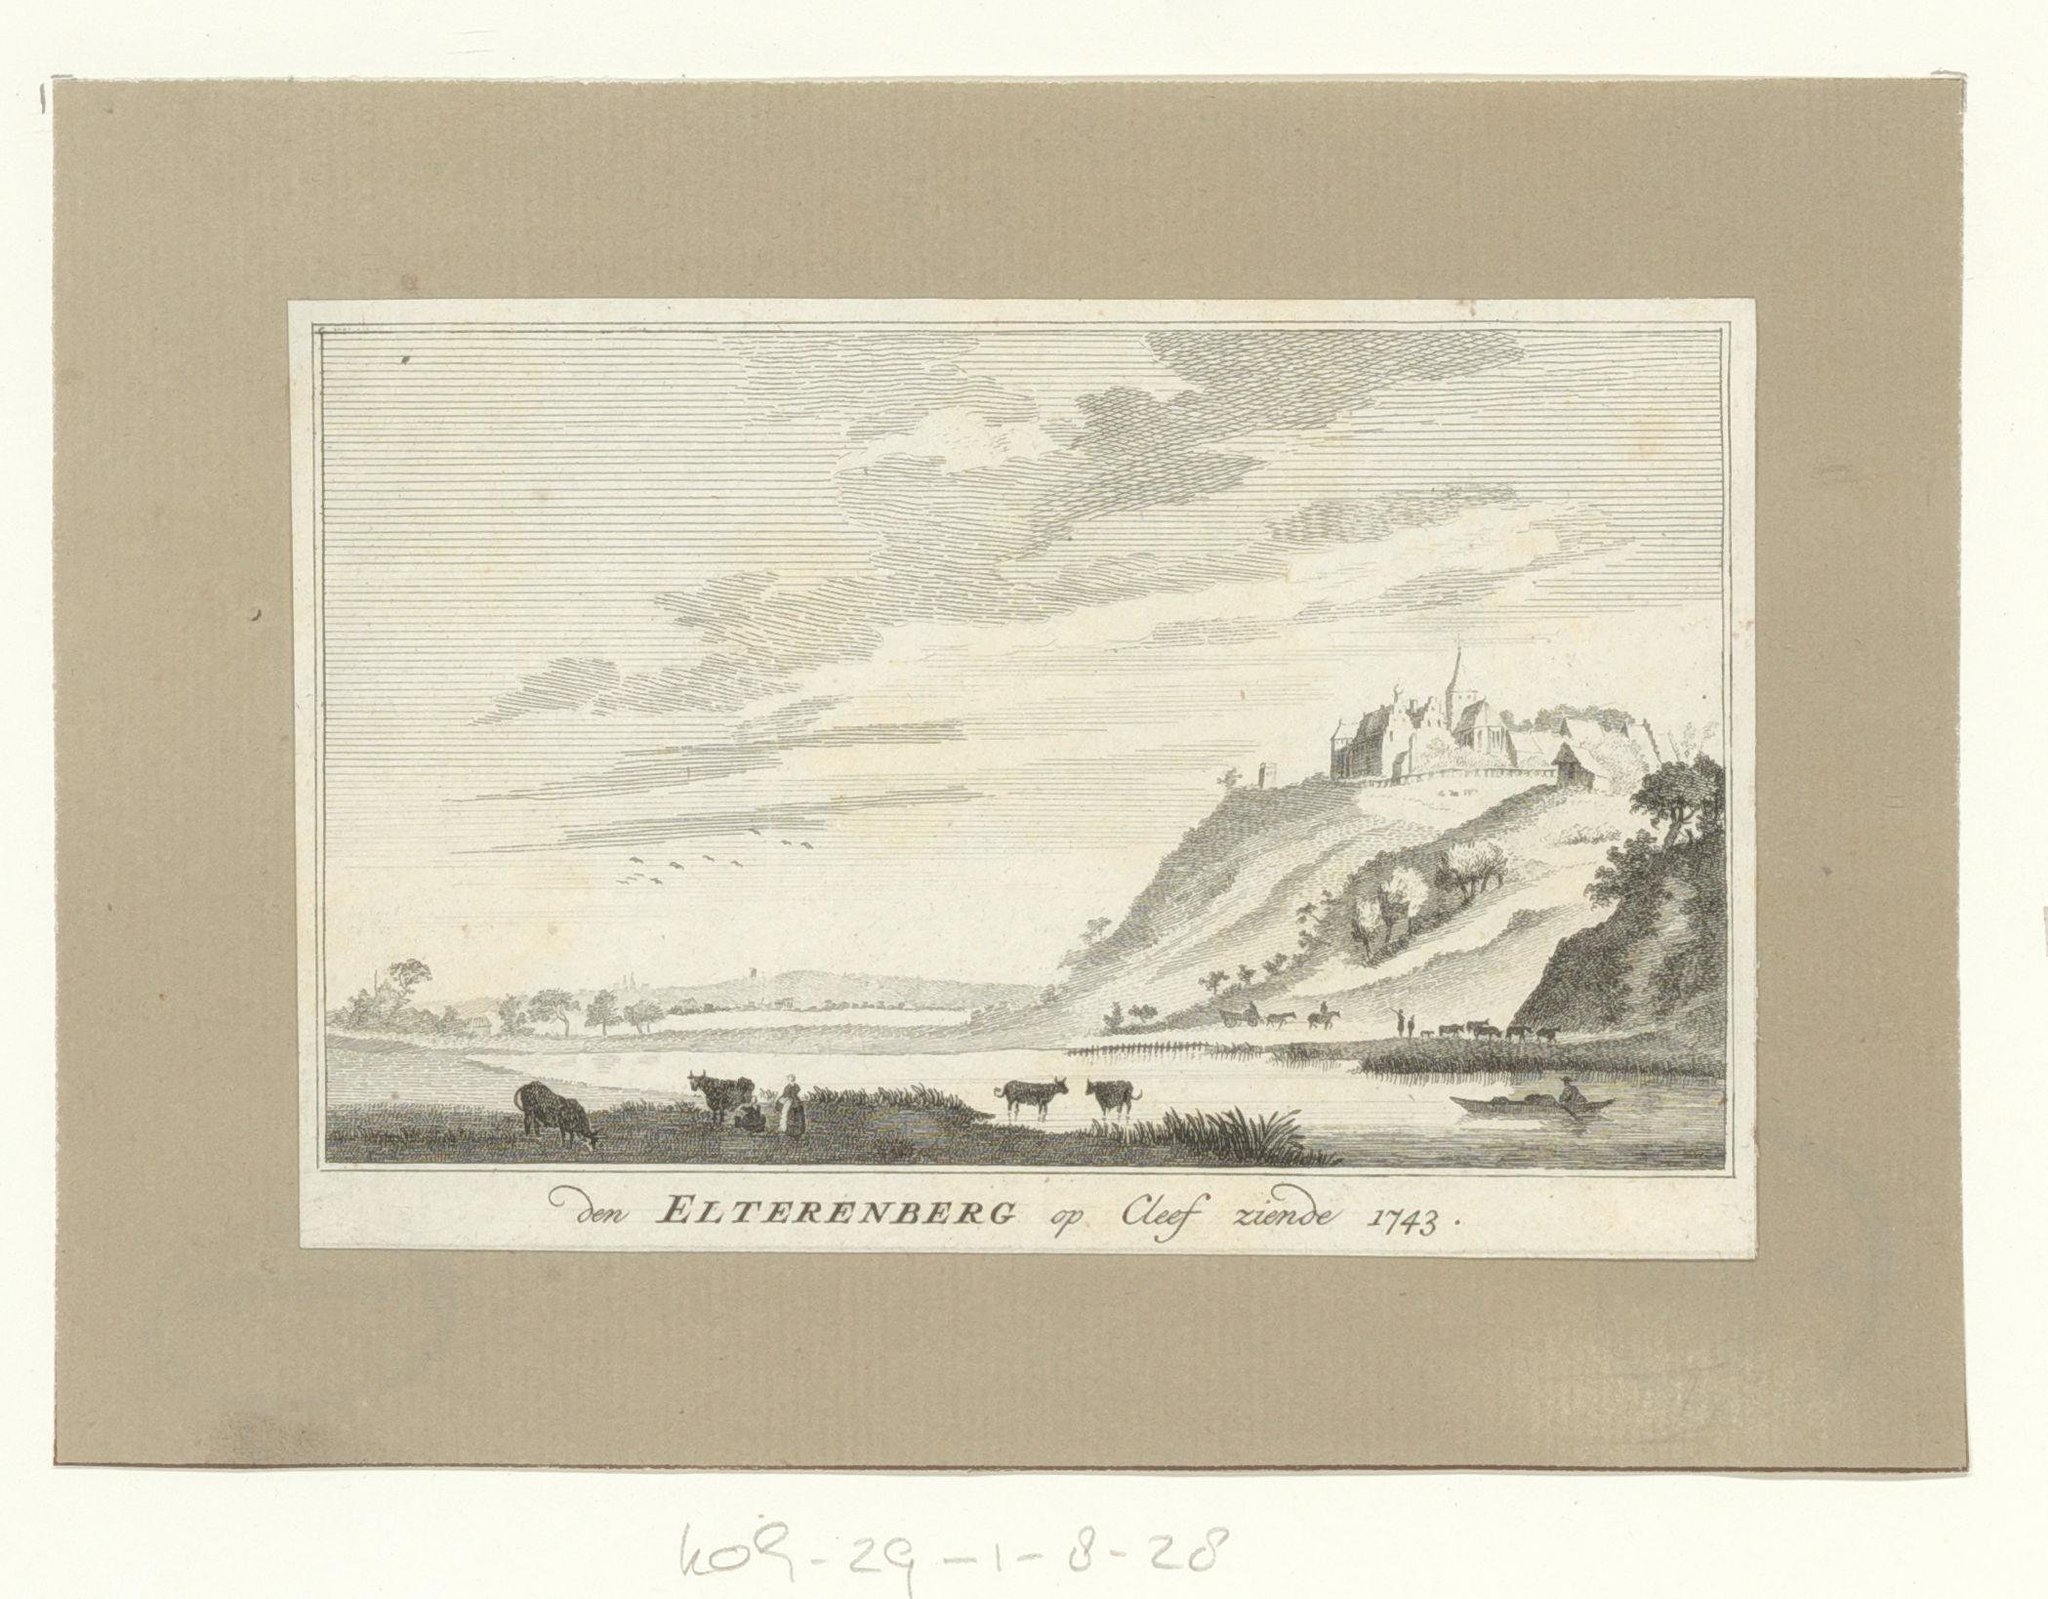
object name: print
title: Dorps- en stadsgezichten te Kleef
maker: paulus van liender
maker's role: draughtsman, print maker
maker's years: 1731-1797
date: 1761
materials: paper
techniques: etching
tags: river, village, church (exterior)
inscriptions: collector's mark: Lugt 1641, collector's mark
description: Gezicht op de Eltenberg waarop het dorp Hoog-Elten met de Sint-Vituskerk ligt, omstreeks 1743. Helft van een plaat met twee voorstellingen. De prent maakt deel uit van een 100-delige serie met gezichten op dorpen en steden te Kleef. Onderwerpsrubrieken binnen de Atlas Zeden en Gewoonten: Kerk en kerkwezen & Armwezen en liefdadige instellingen; Kerkgebouwen elders. A-E.